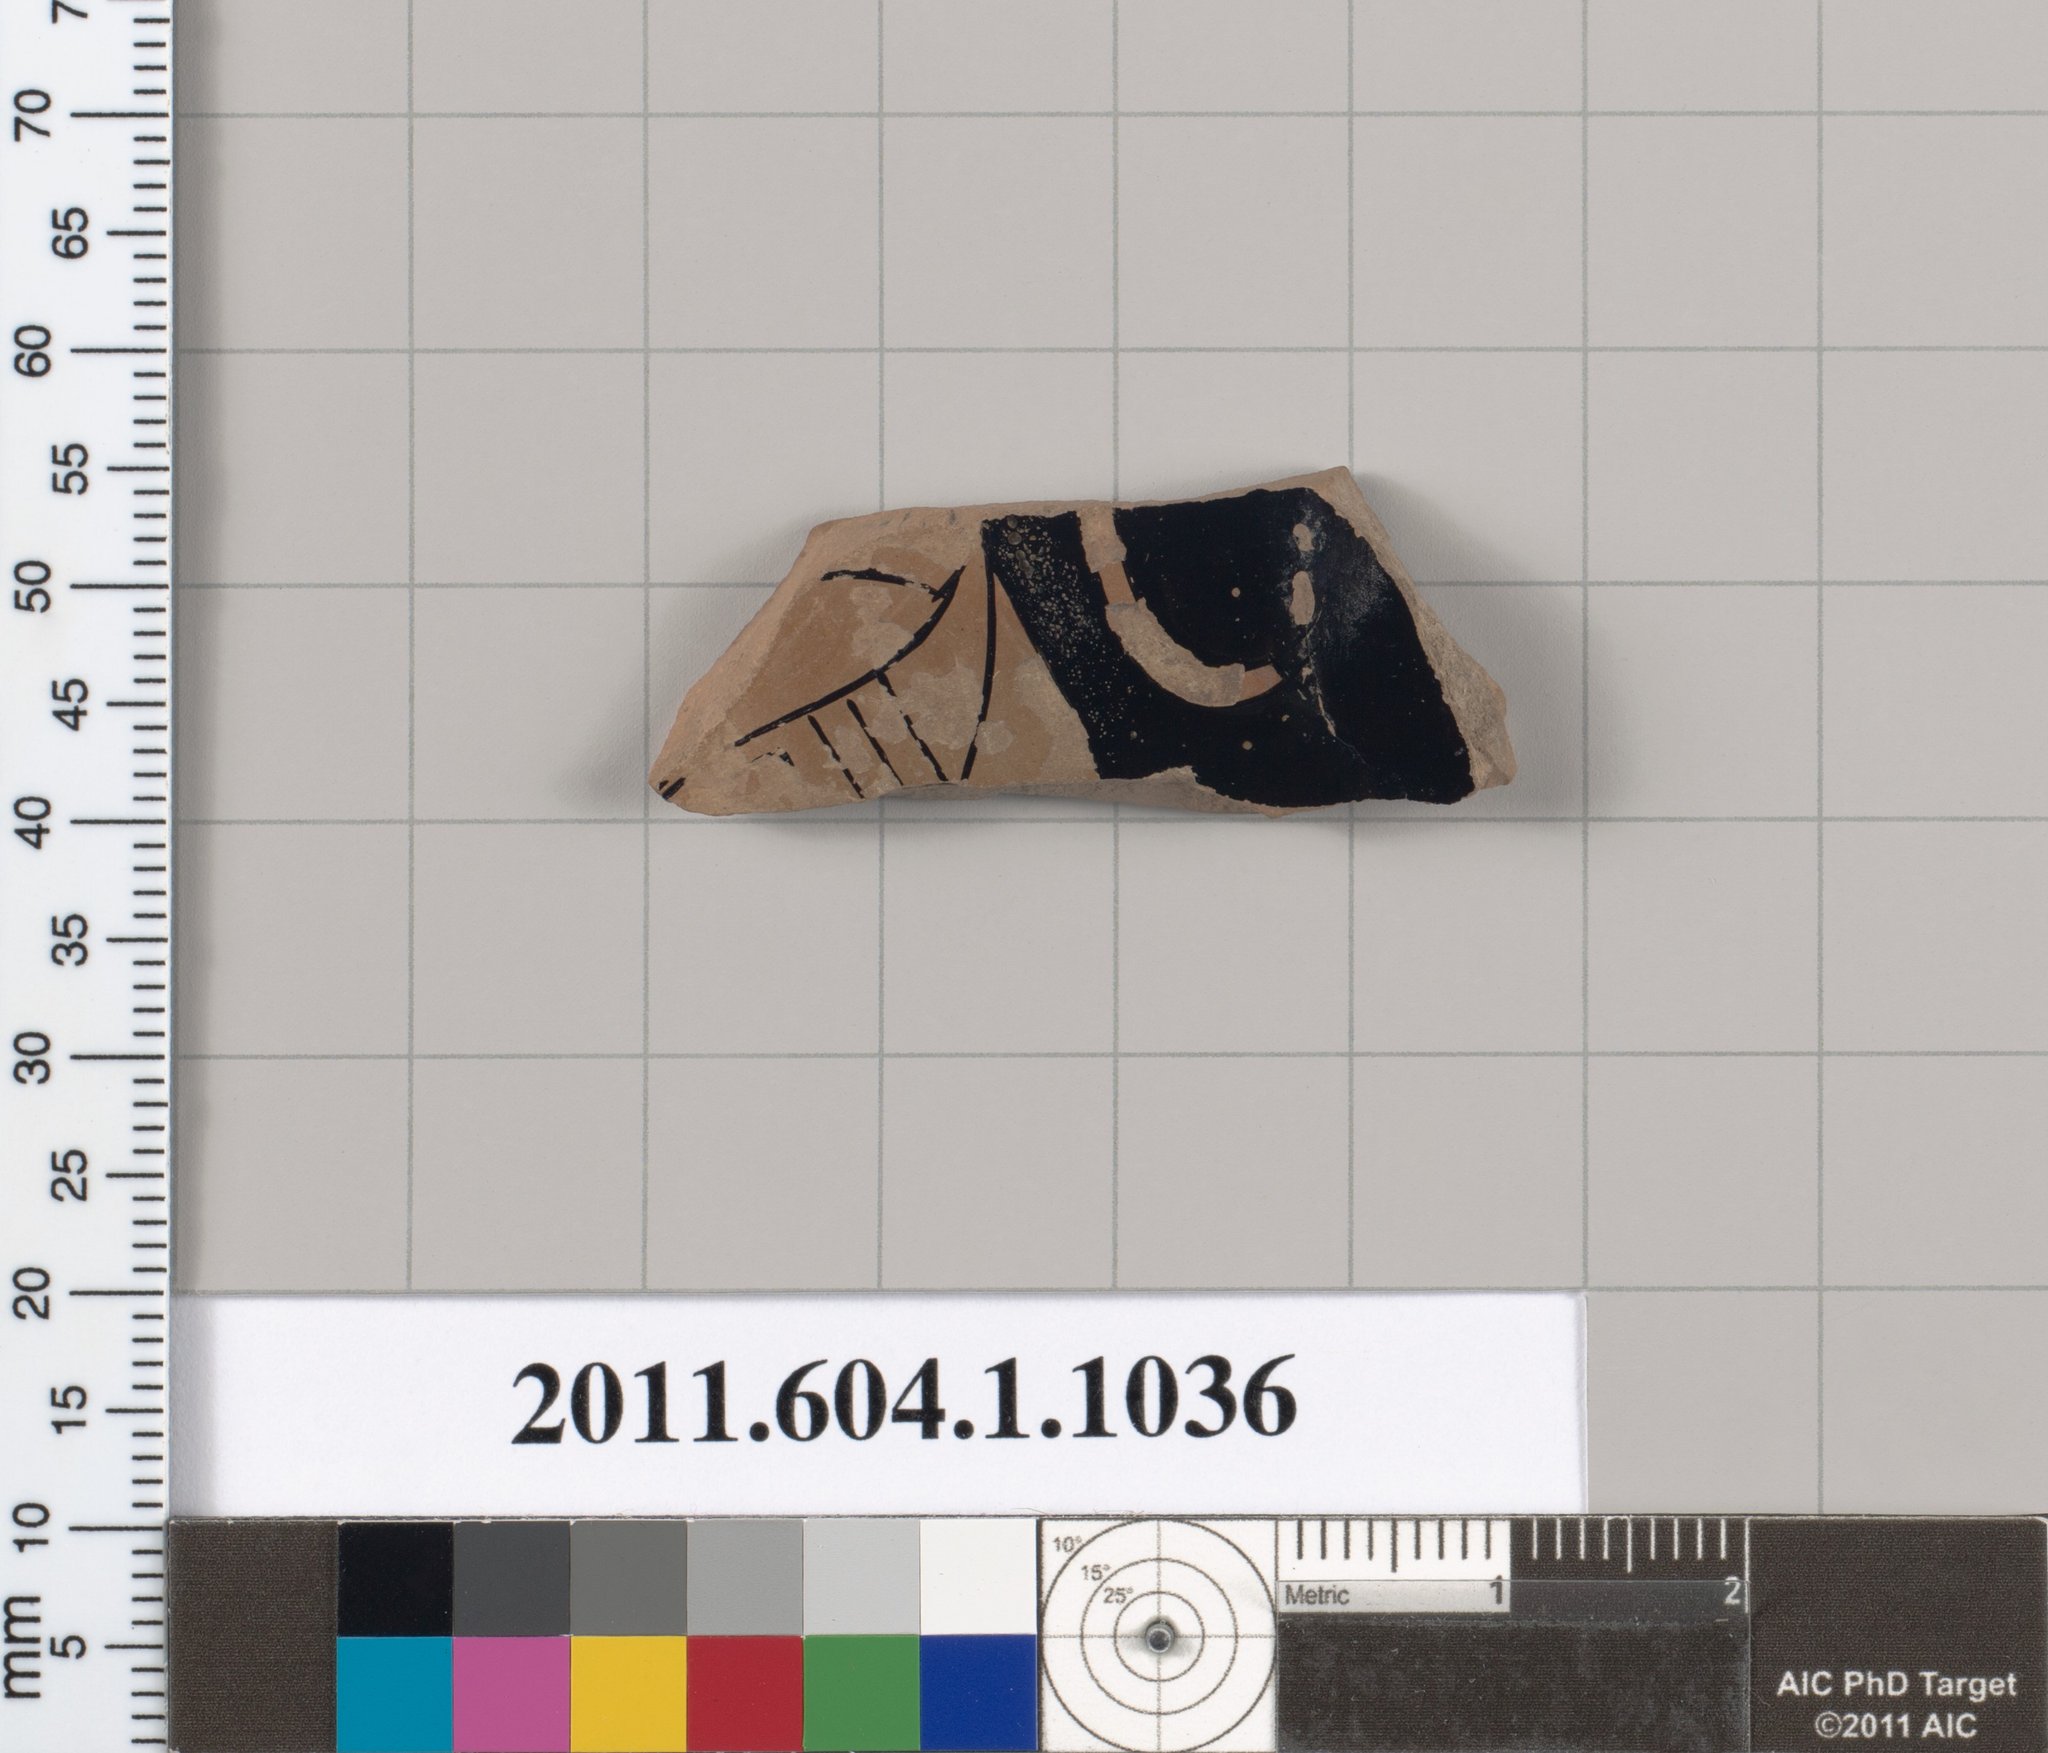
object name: kylix fragment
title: Terracotta fragment of a kylix (drinking cup)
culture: greek, attic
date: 475-451 BCE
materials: terracotta